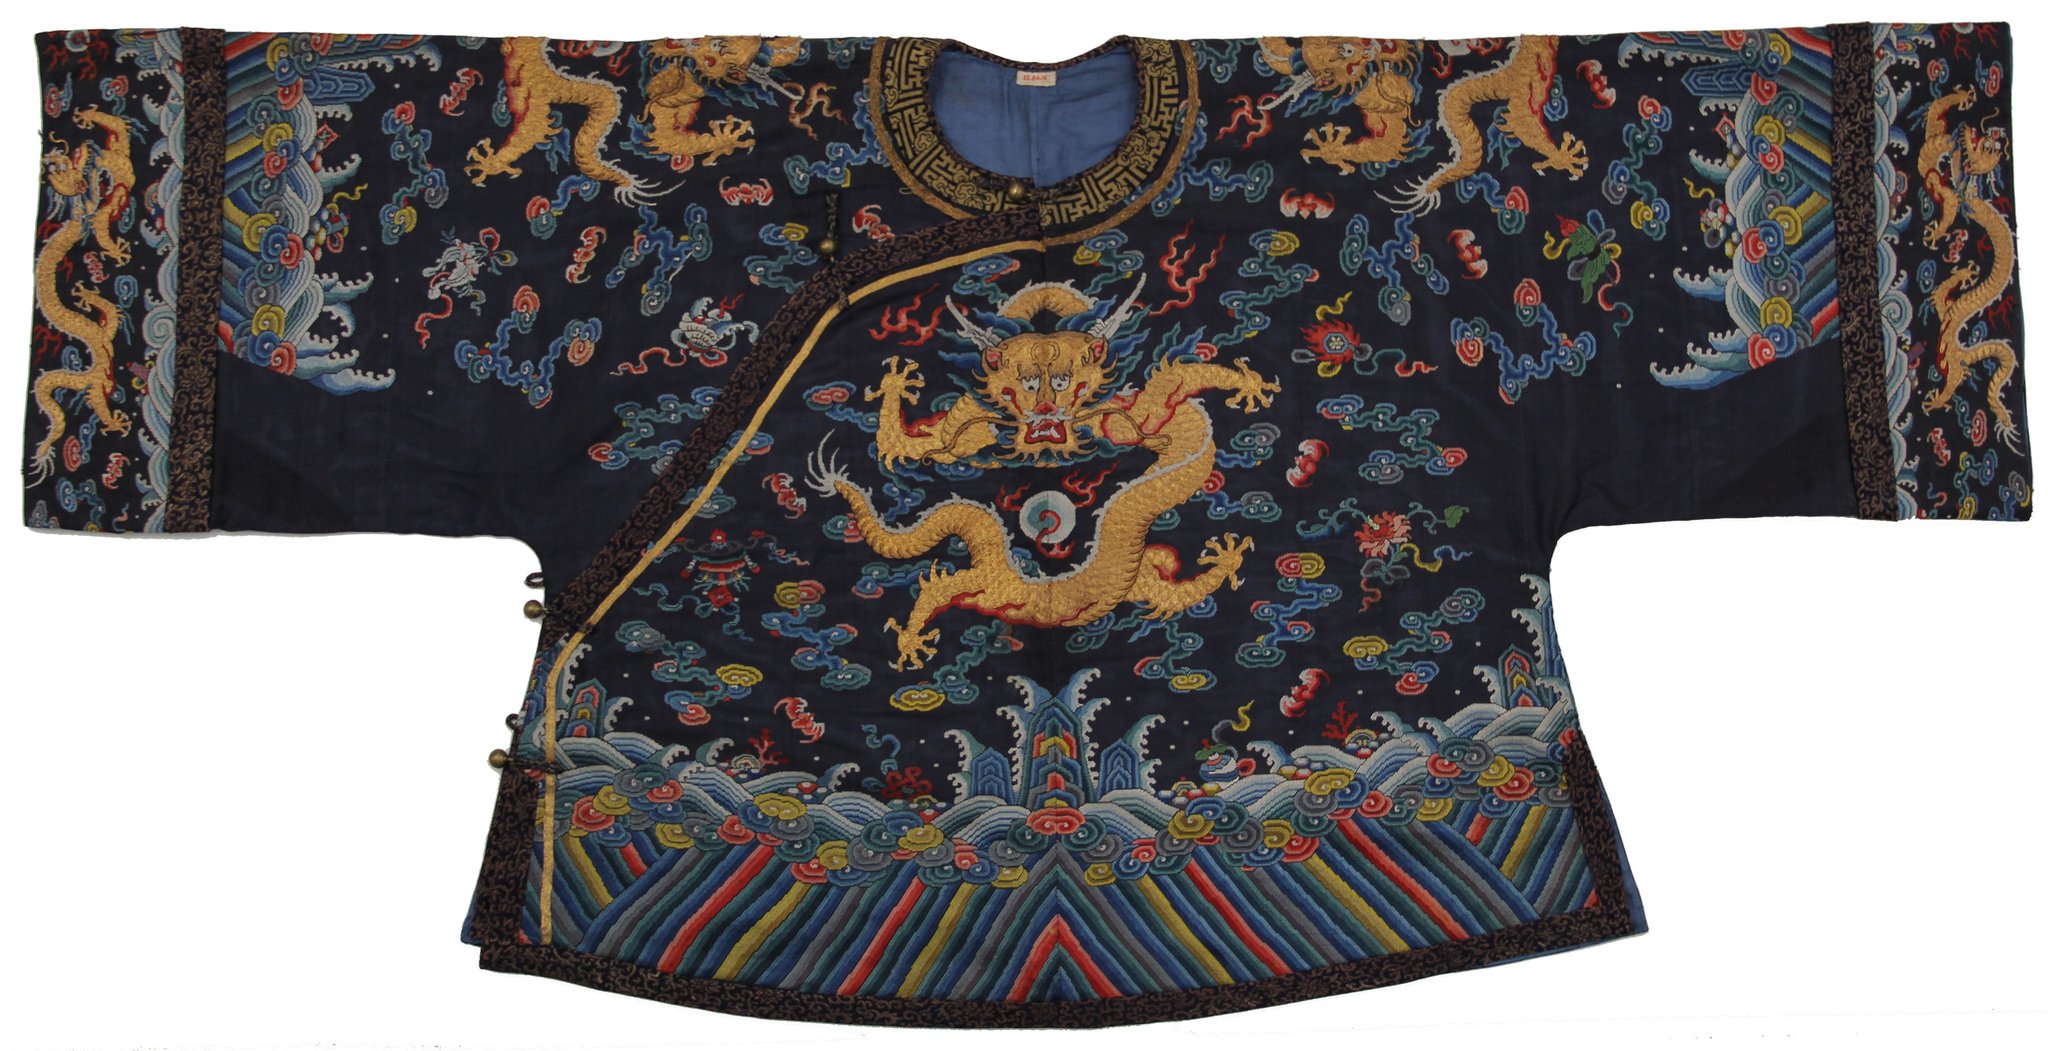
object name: jacket, court, summer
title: Summer Jacket Court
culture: chinese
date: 1701-1733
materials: metal thread, silk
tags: dragons